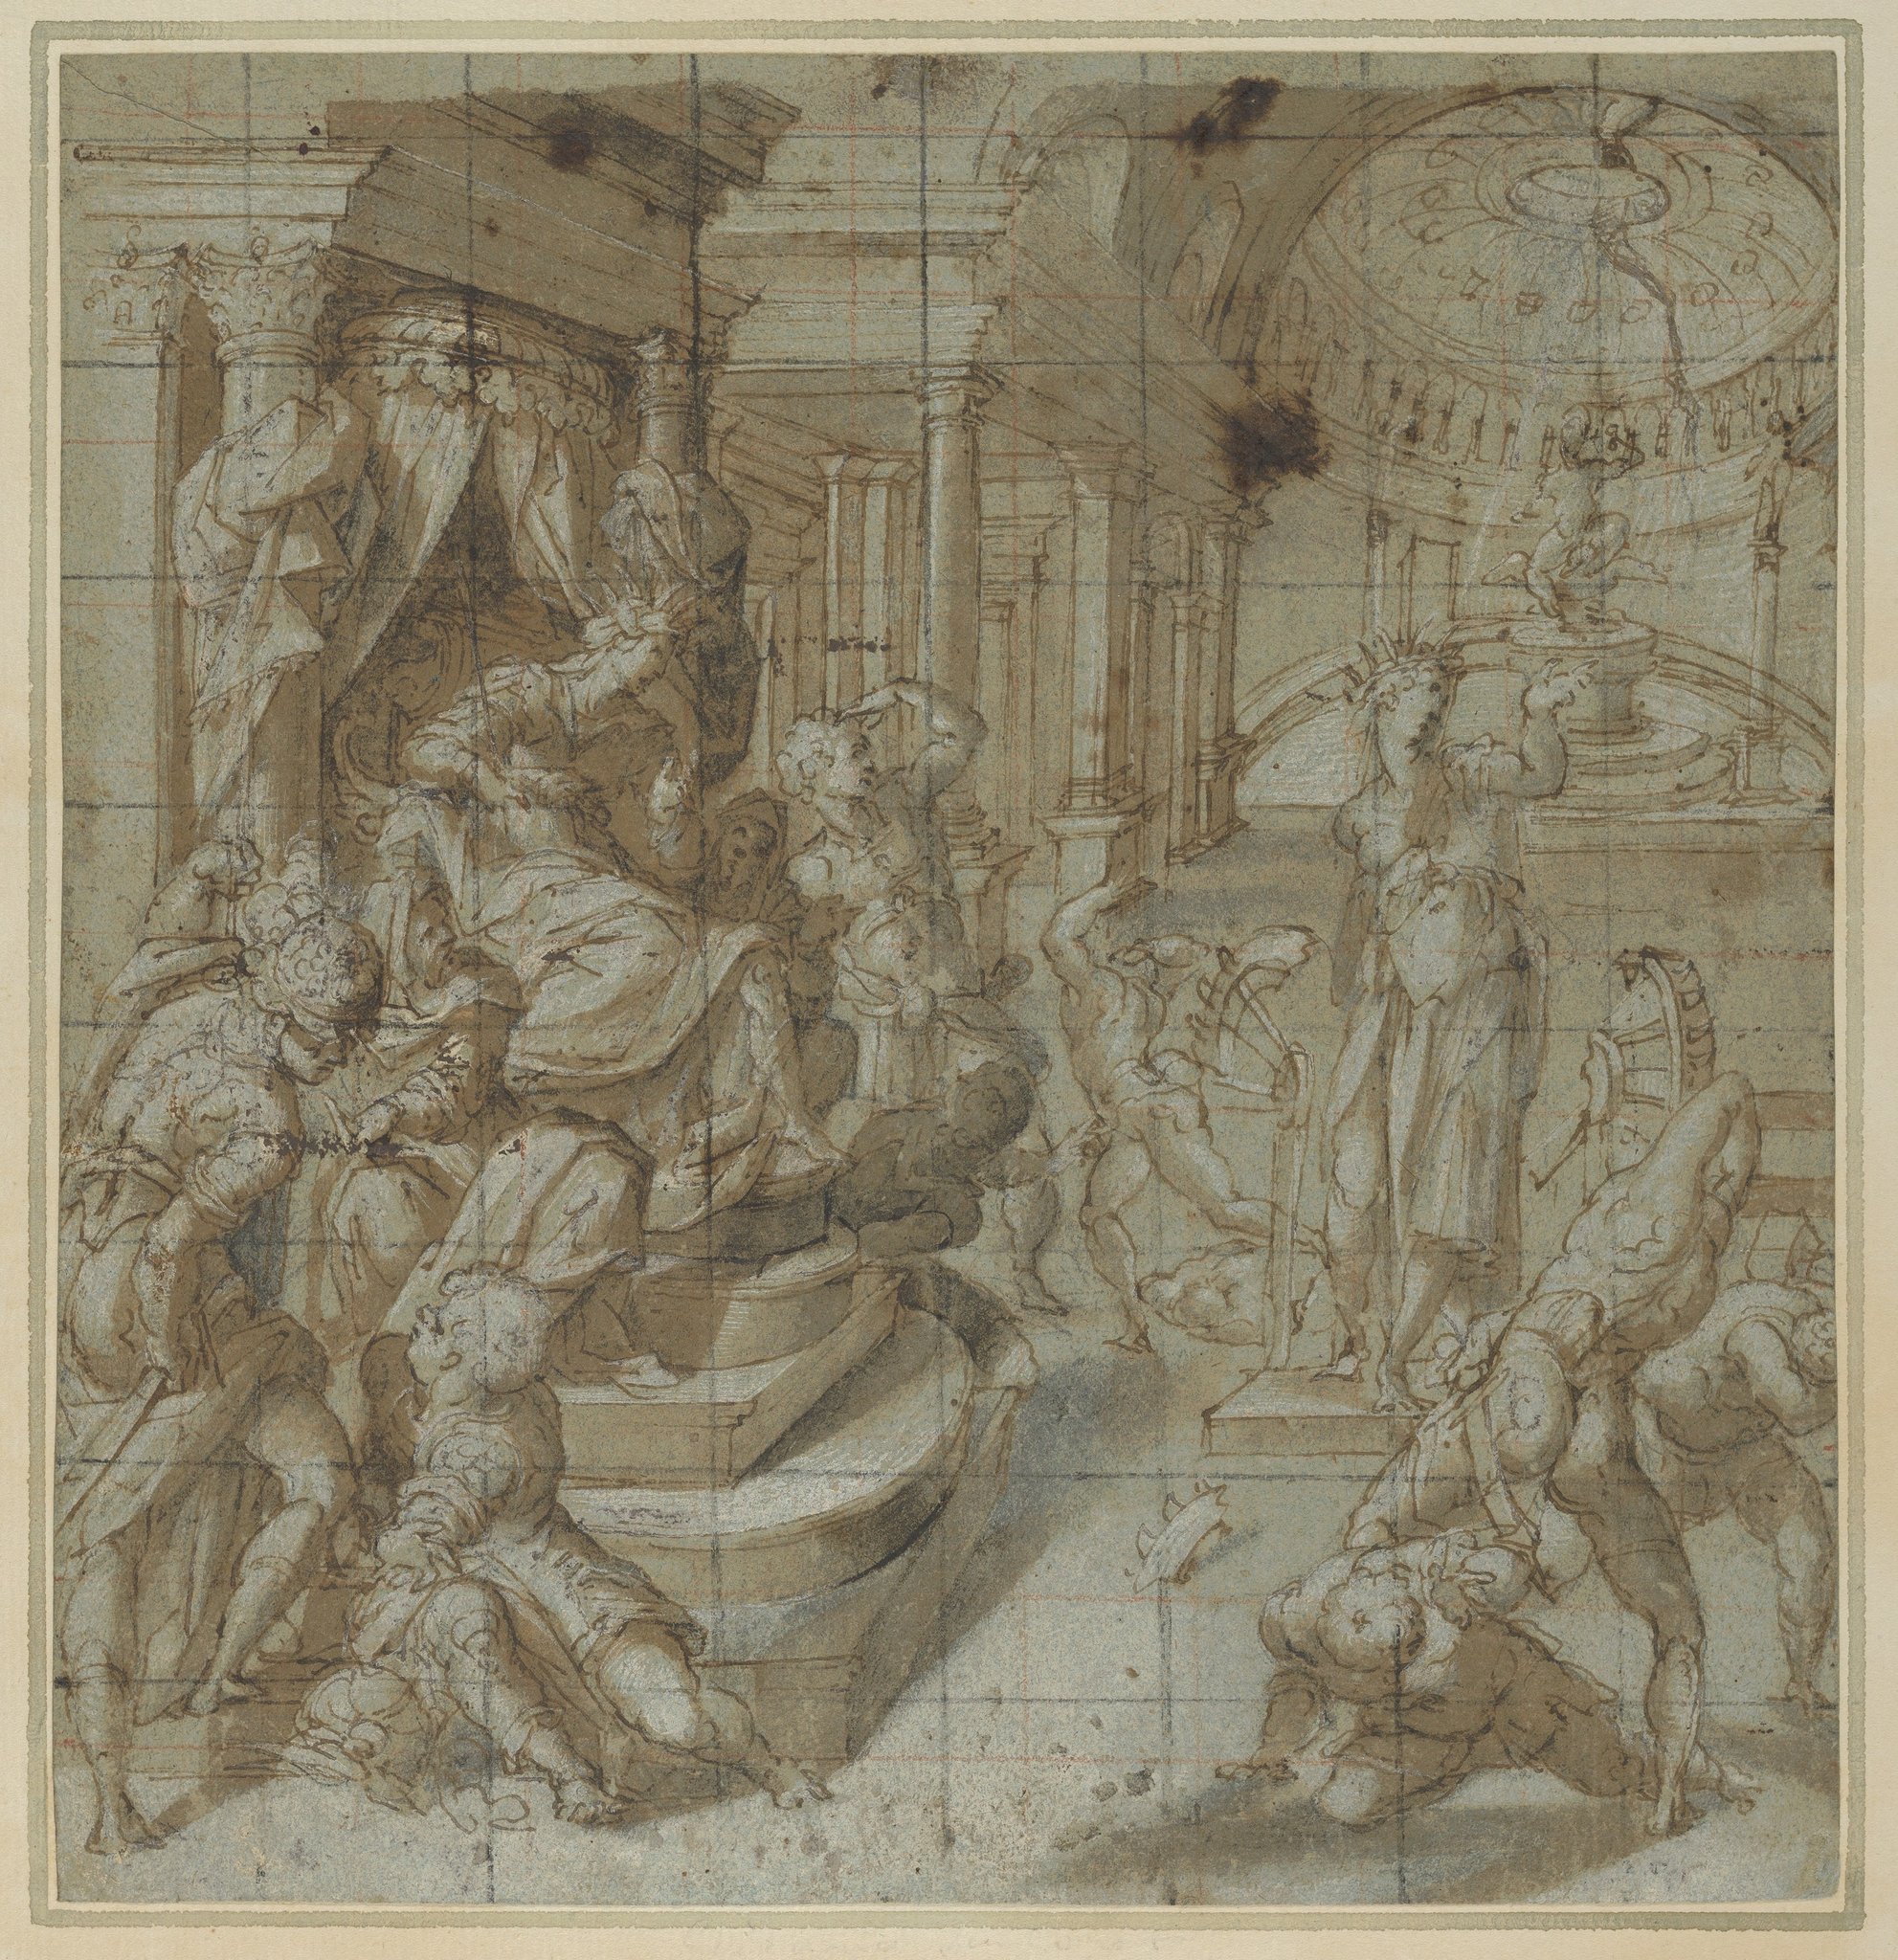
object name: drawing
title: The Martyrdom of St. Catherine of Alexandria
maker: carlo portelli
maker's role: artist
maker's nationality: italian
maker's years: 1510-1574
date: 1560-1570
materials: chalk, gouache, ink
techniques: brush, highlighting, pen, drawing, wash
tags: men,saint catherine